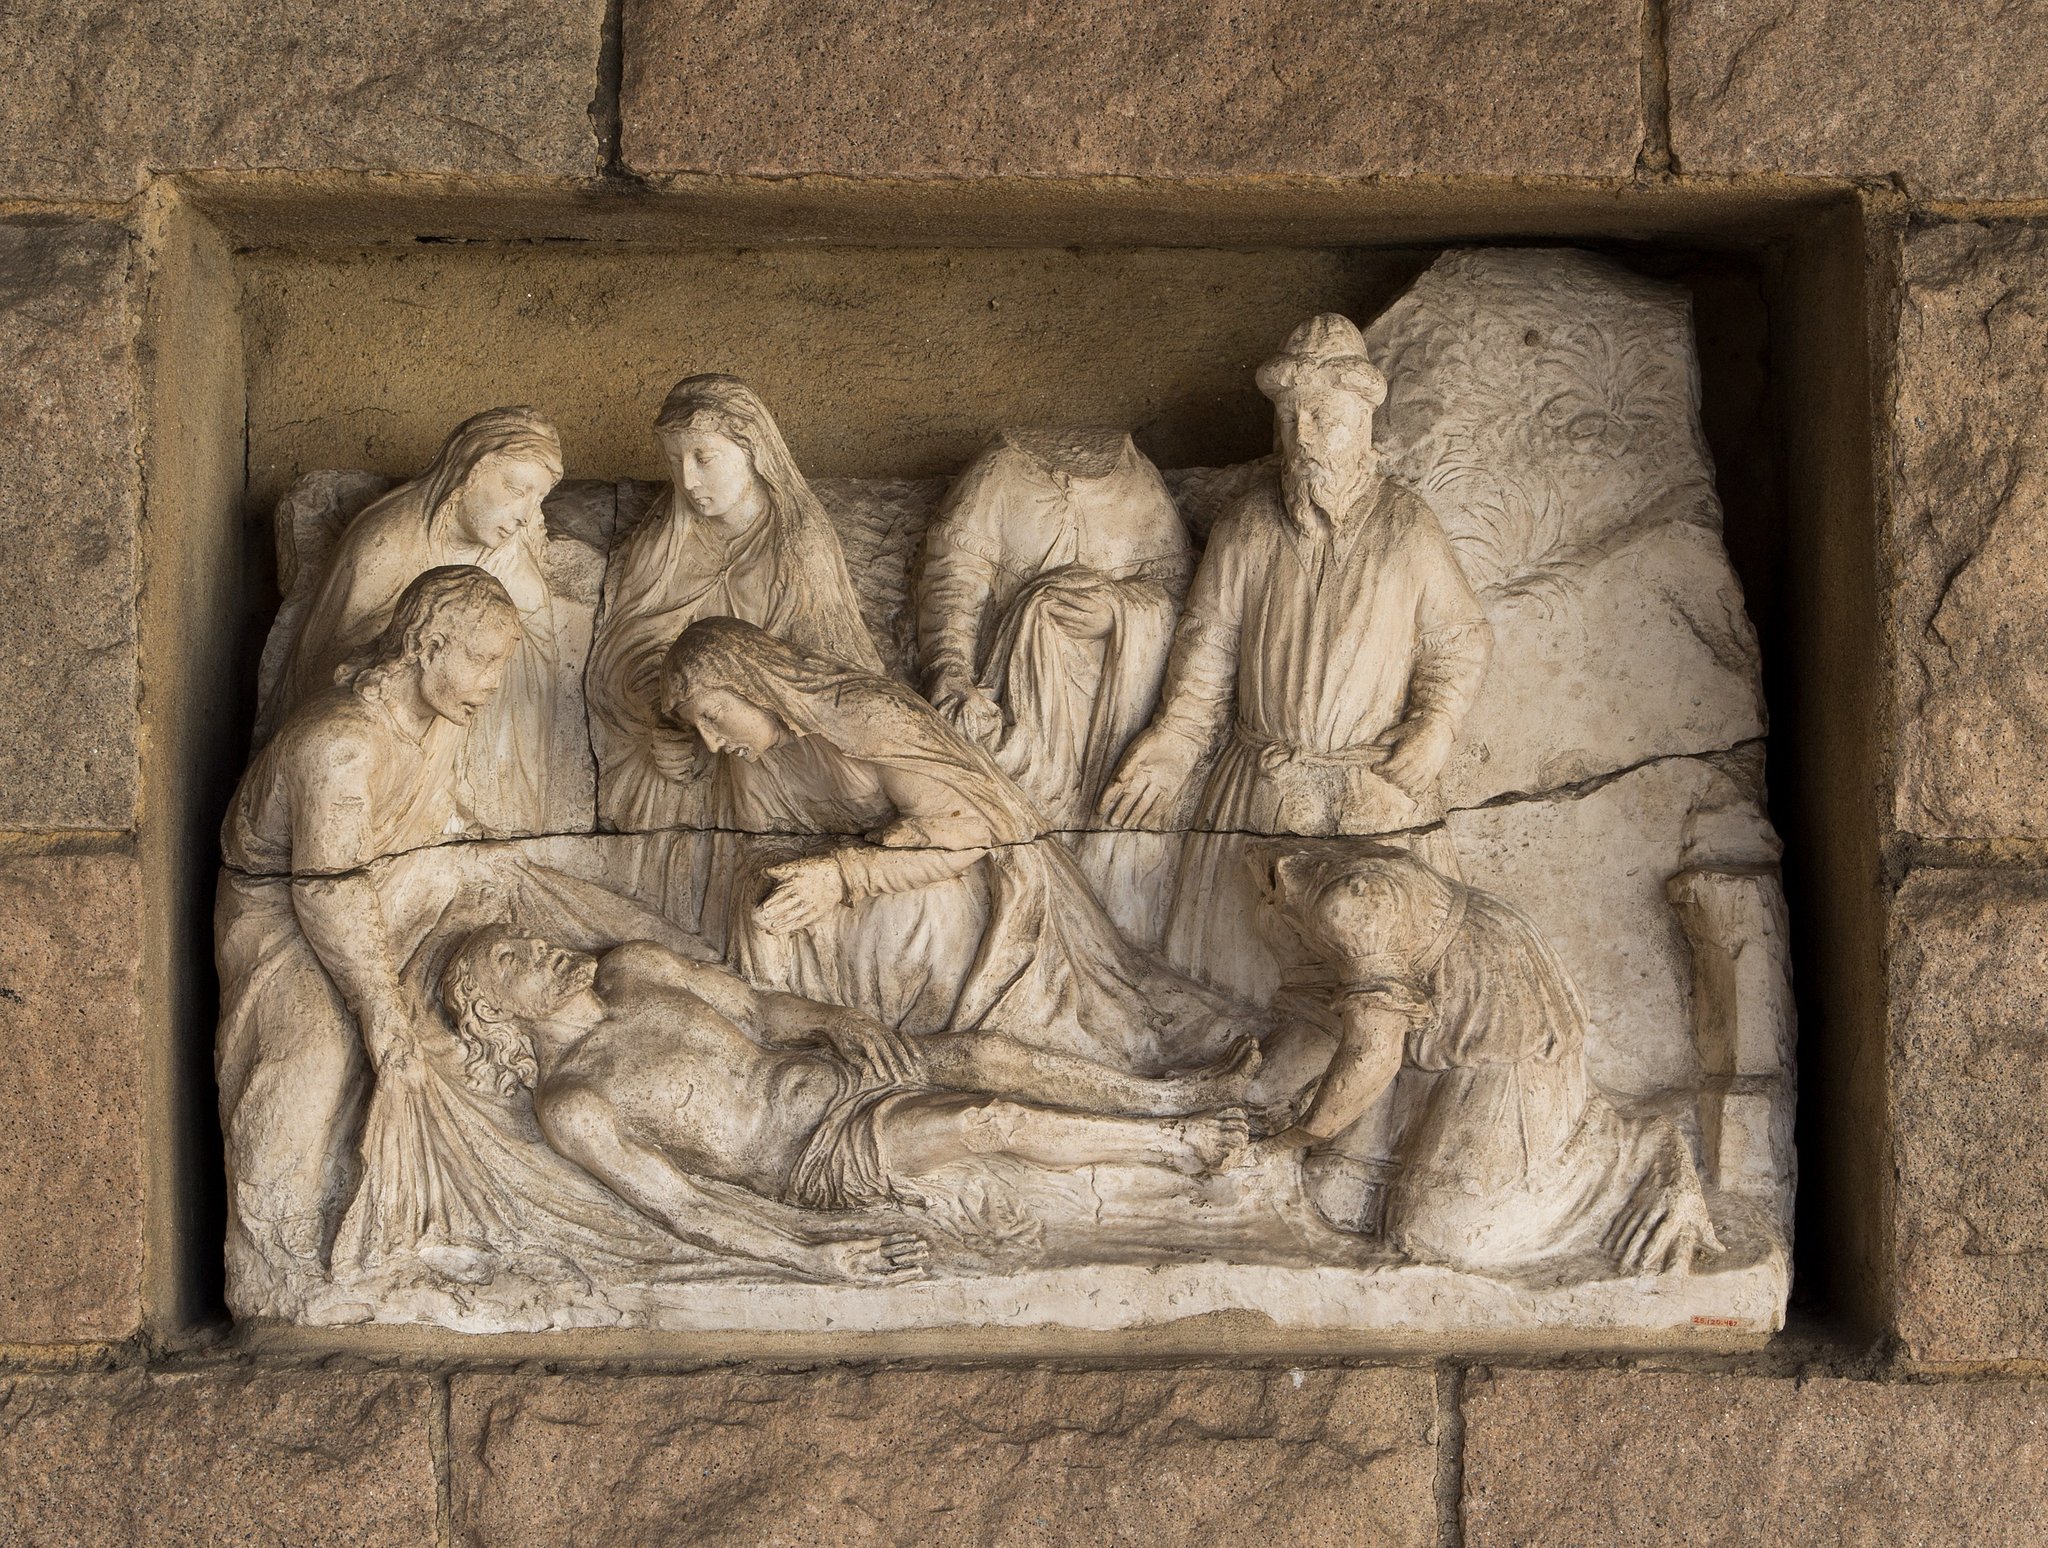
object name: relief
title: The Entombment (from Scenes from the Passion of Christ)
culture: french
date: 1501-1533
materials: stone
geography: france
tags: christ,mary magdalene,virgin mary,entombment